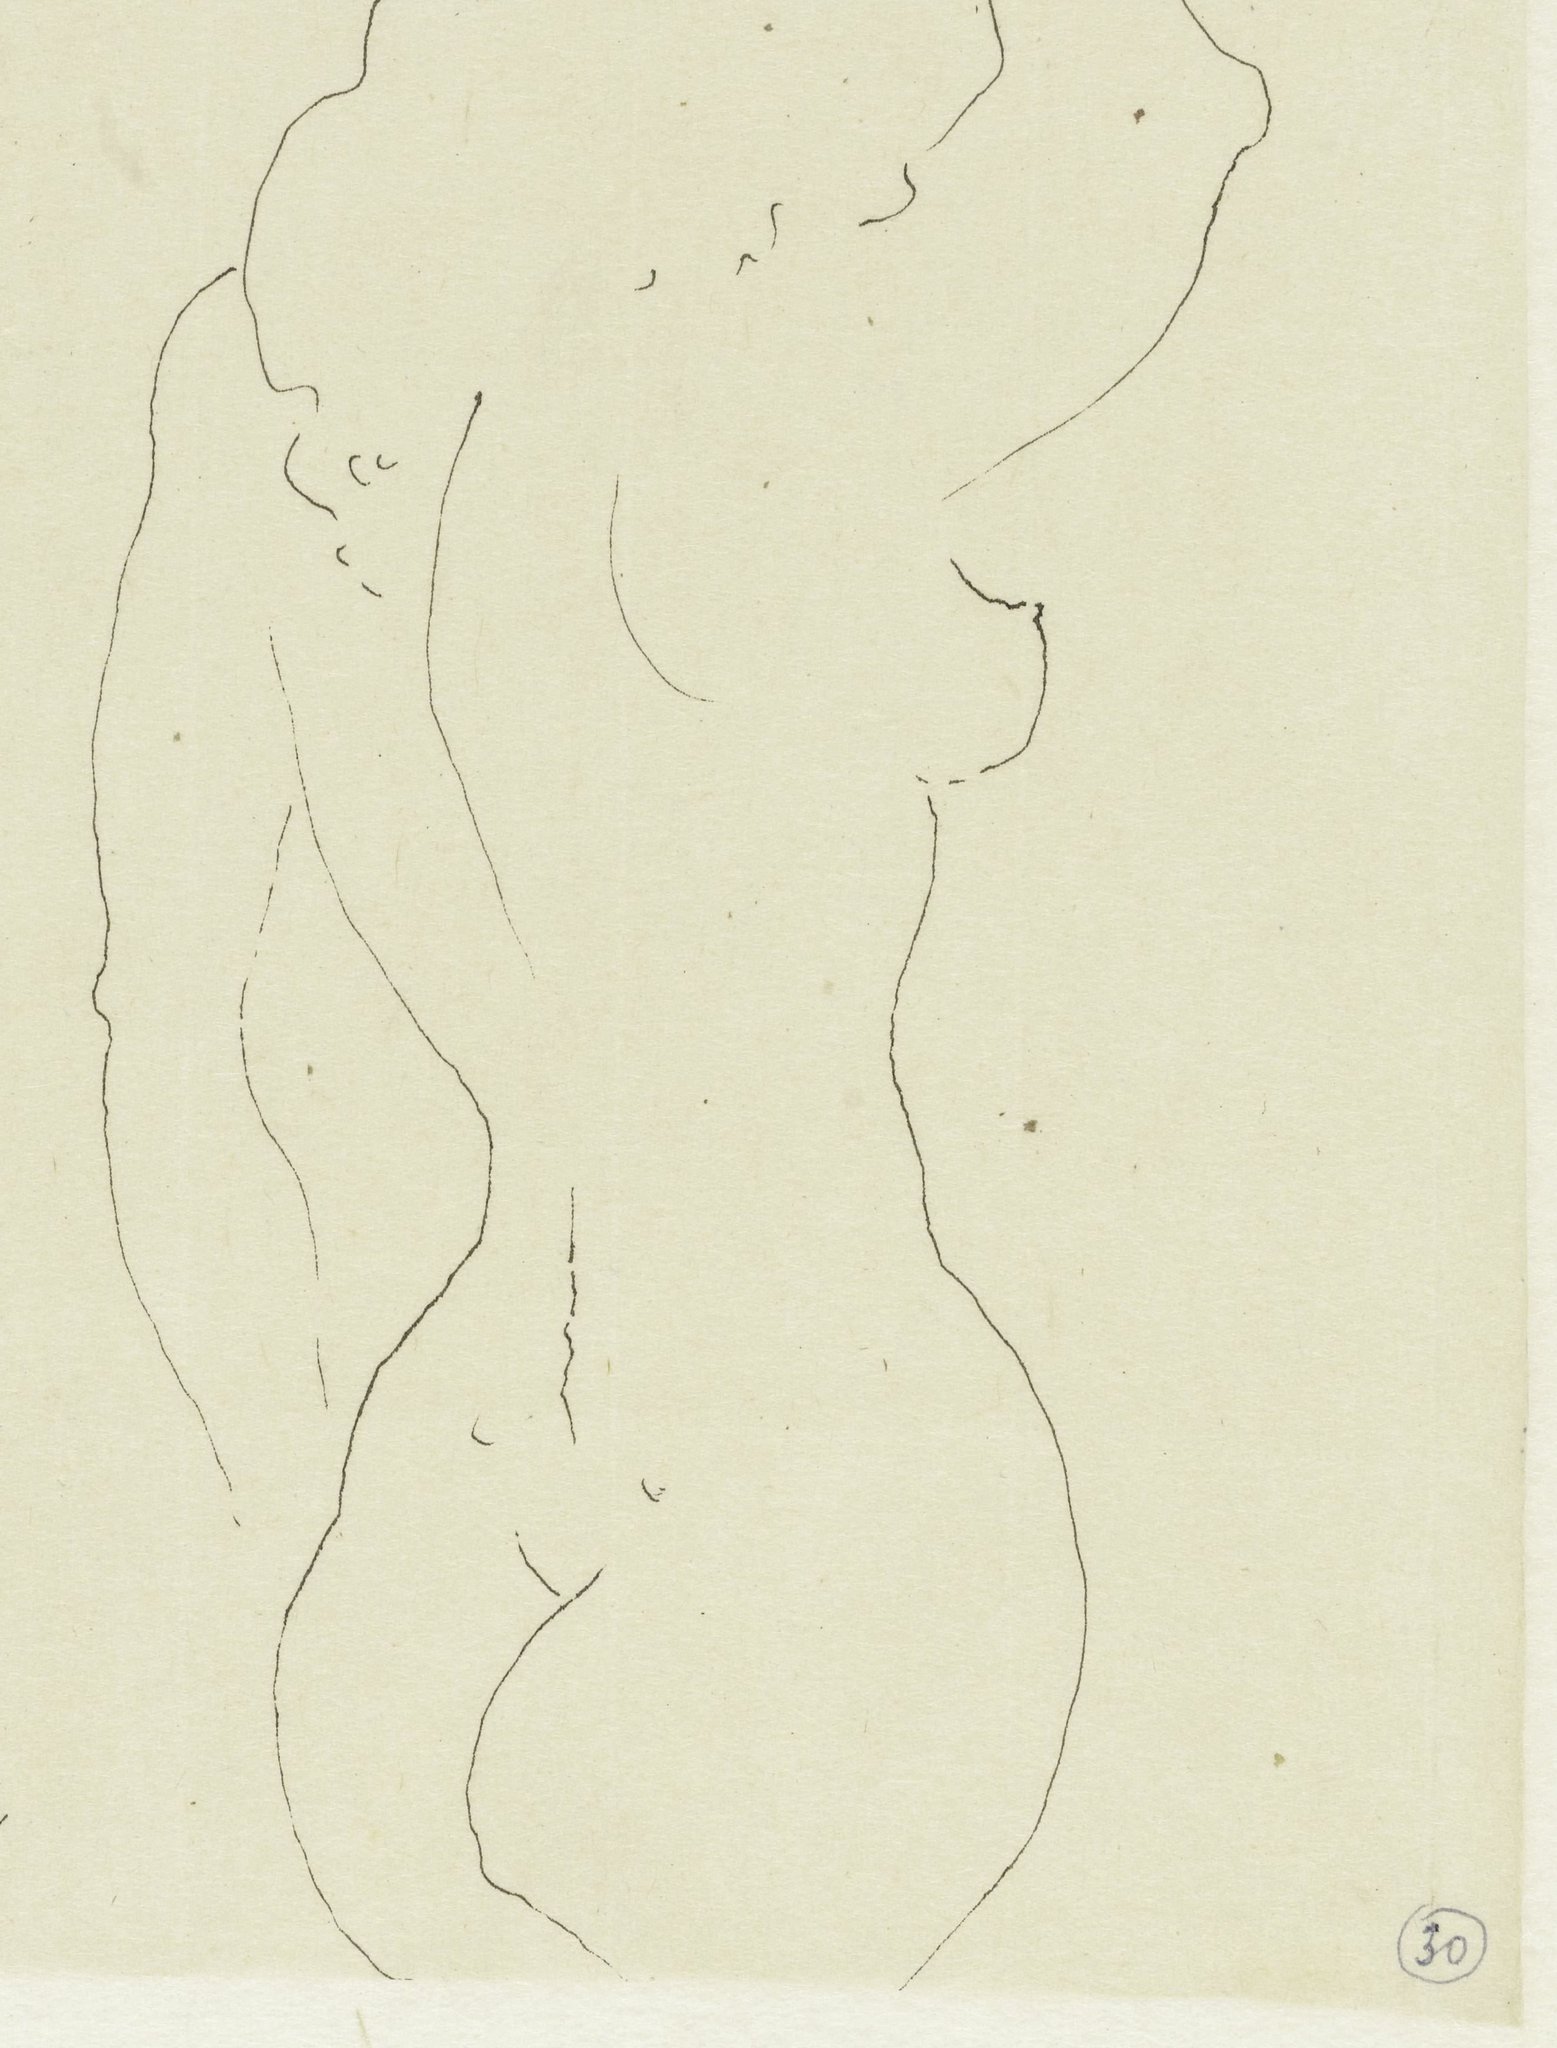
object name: drawing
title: Staand vrouwelijk naakt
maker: tinus van doorn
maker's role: painter, print maker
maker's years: 1905-1940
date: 1931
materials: ink, paper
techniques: pen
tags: the (nude) human figure; 'corpo humano' (ripa) - aa - female human figure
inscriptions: inscription: ‘Januari’, collector's mark: Lugt 2228, inscription: ‘30’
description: Van achteren gezien en met haar rechterarm boven haar hoofd.